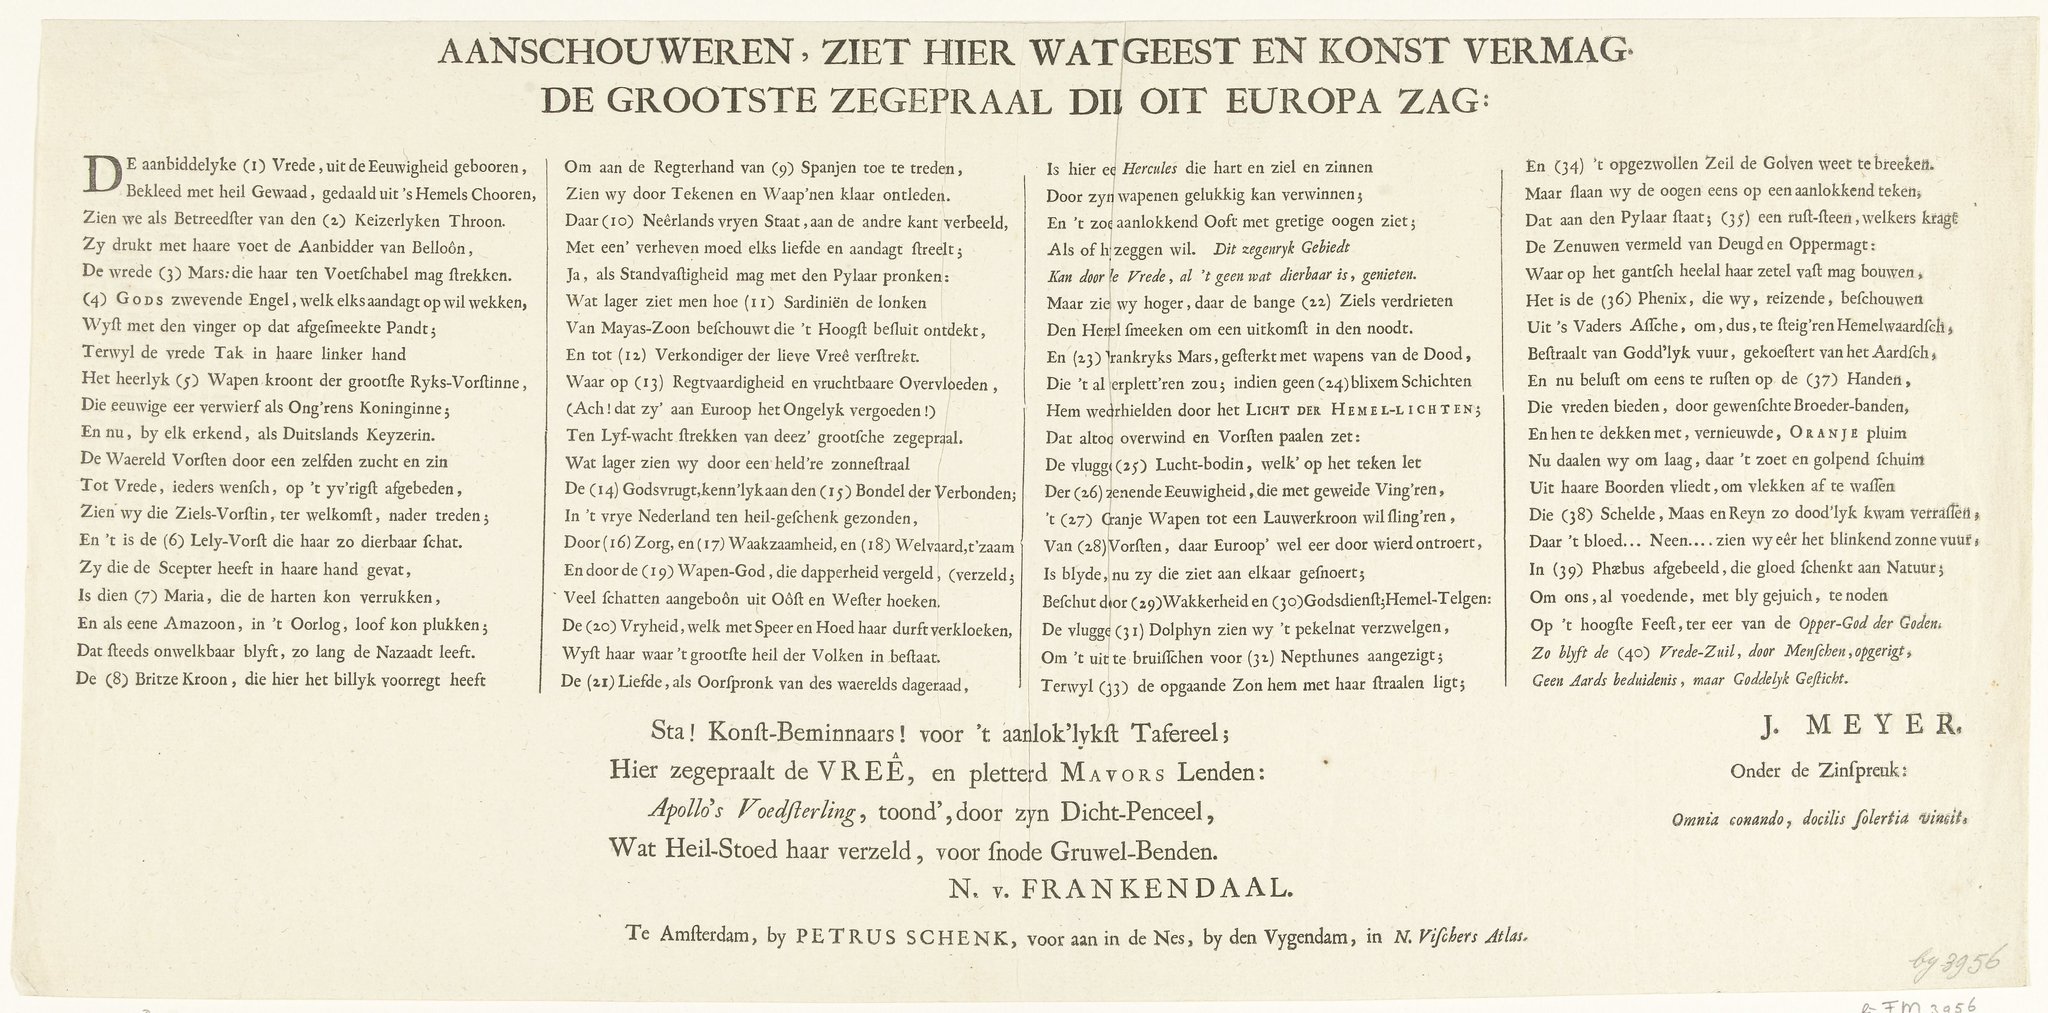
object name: text sheet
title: Tekstblad bij de Allegorie op de Vrede van Aken, 1748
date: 1748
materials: paper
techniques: letterpress printing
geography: northern netherlands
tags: vrede van aken (1748)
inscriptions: collector's mark: Lugt 2228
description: Tekstblad bij de prent met de Allegorie op de Vrede van Aken gesloten op 18 oktober 1748 tussen de Geallieerden (Republiek, Engeland en Oostenrijk) enerzijds en Frankrijk, Pruisen en Spanje anderzijds. Verklaring van de voorstelling in versvorm in vier kolommen en een vierregelig vers.